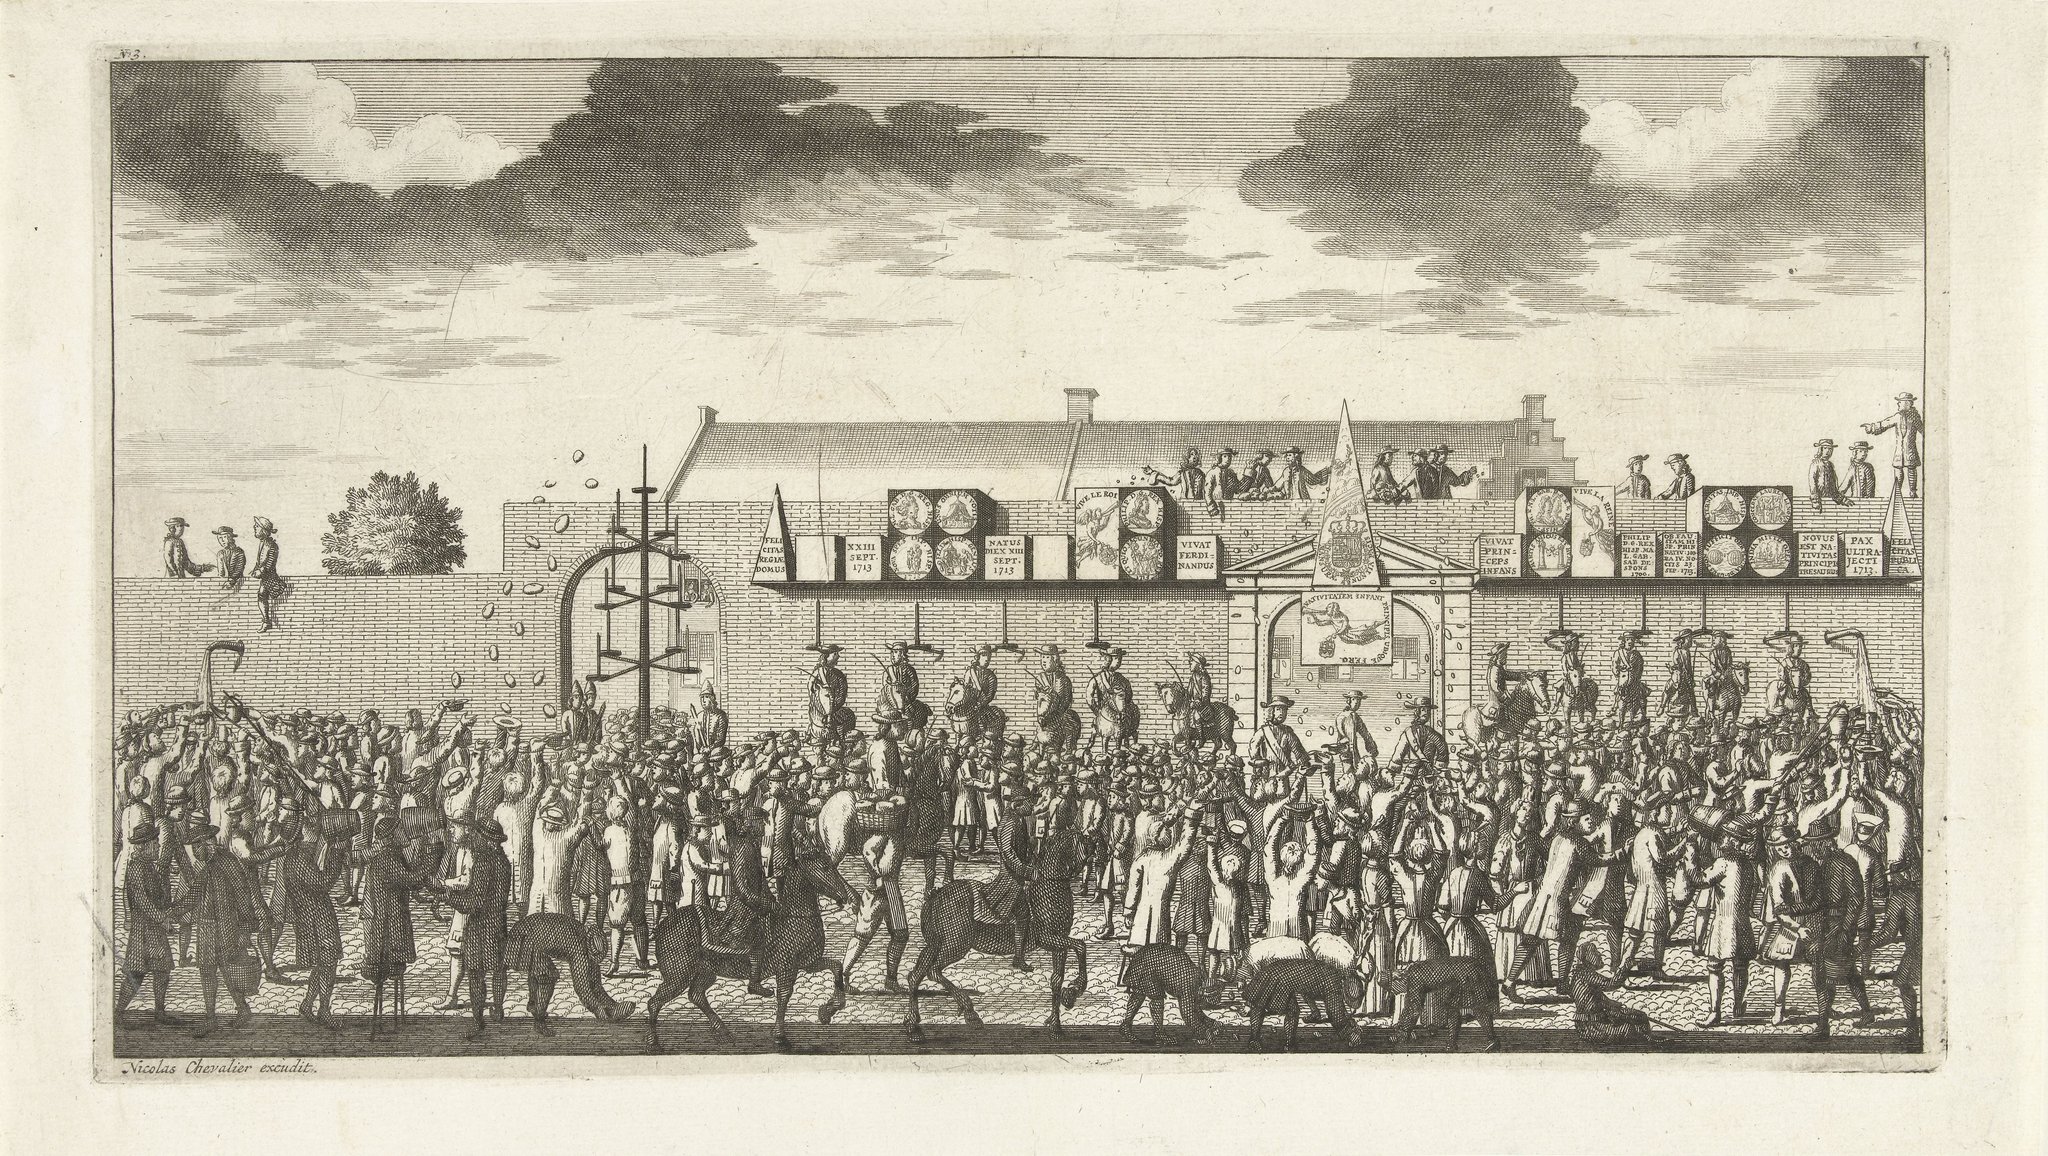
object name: print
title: Straatfeest, 1713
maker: nicolas chevalier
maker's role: print maker, publisher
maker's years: 1661-1720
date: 1713-1714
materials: paper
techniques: etching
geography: utrecht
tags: public festivities at birth of royal persons (+ eating and drinking ~ festive activities), utrecht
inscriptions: collector's mark: Lugt 2228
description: Straatfeest waarbij vanaf een versierde facade gestrooid wordt met eten en drinken gratis getapt wordt, 1713. Onderdeel van een groep van drie illustraties van de feestelijkheden op 9-10 oktober georganiseerd door de hertog van Ossuna, een lid van de Spaanse gezantschap, in het Duitse Huis aan de Springweg te Utrecht ter ere van de geboorte van kroonprins Ferdinand van Castilië op 23 september 1713. Gemerkt linksboven: N. 3.